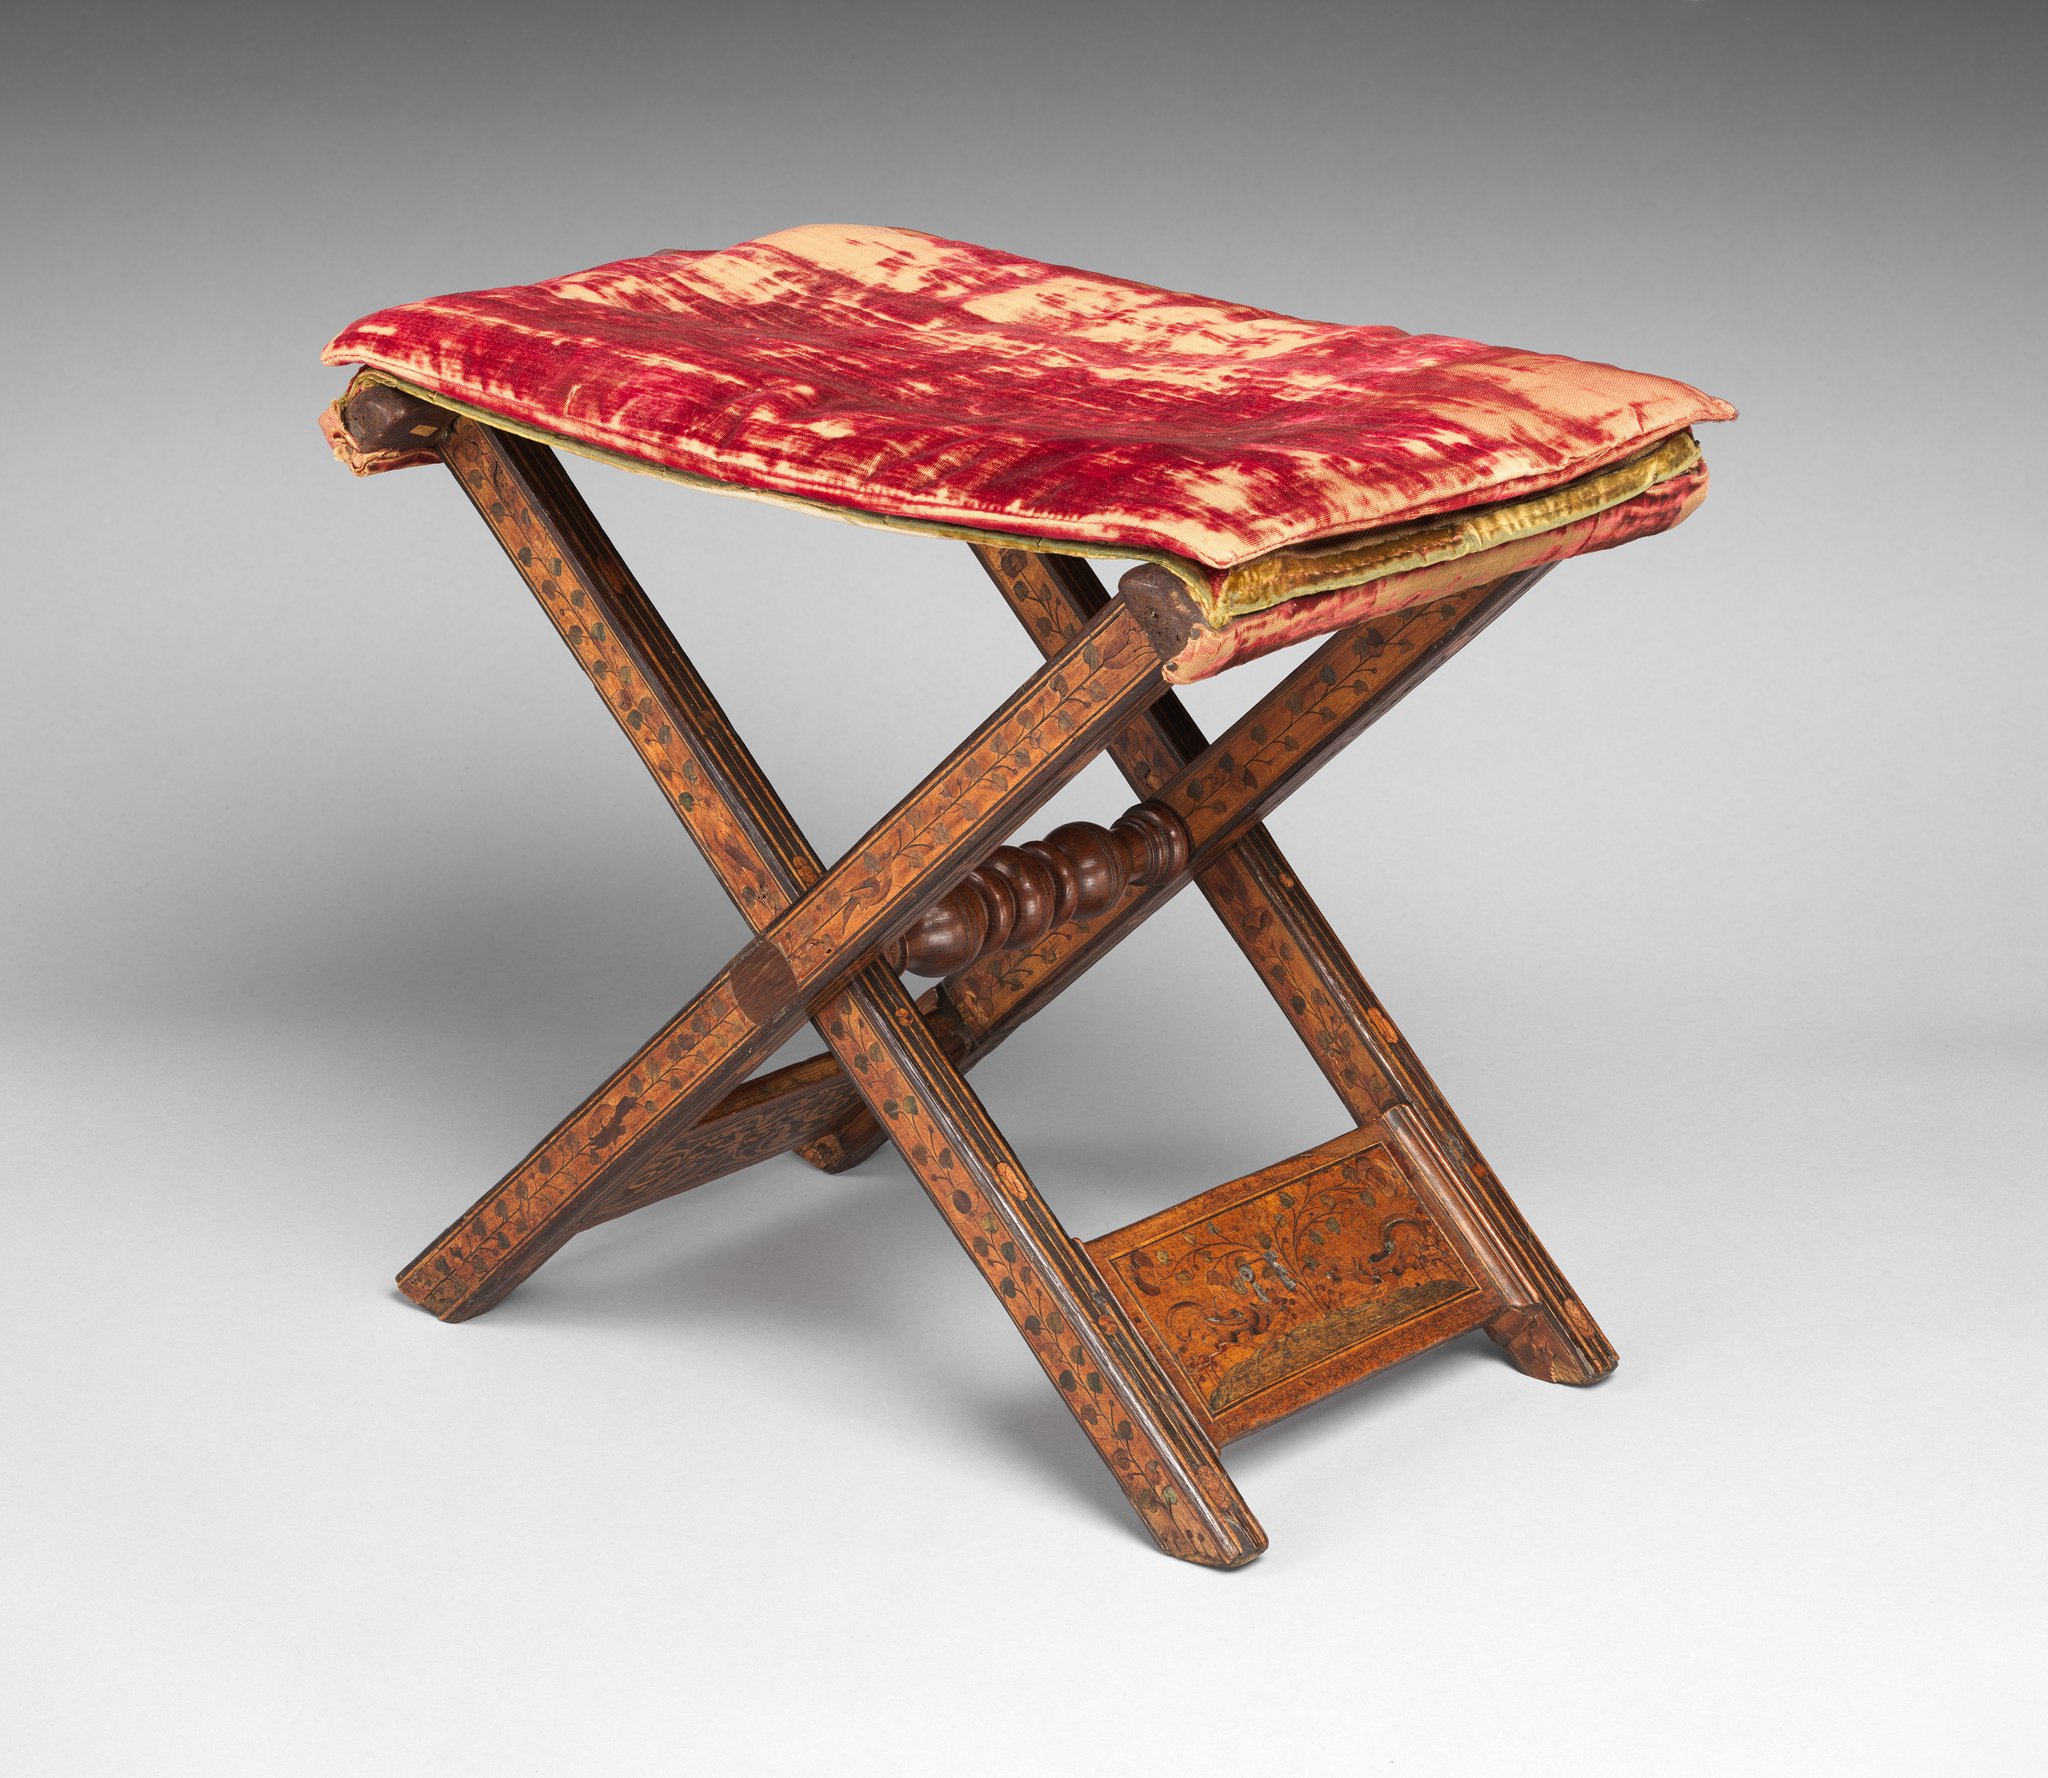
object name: stool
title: Folding stool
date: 1601-1633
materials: wood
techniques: stain